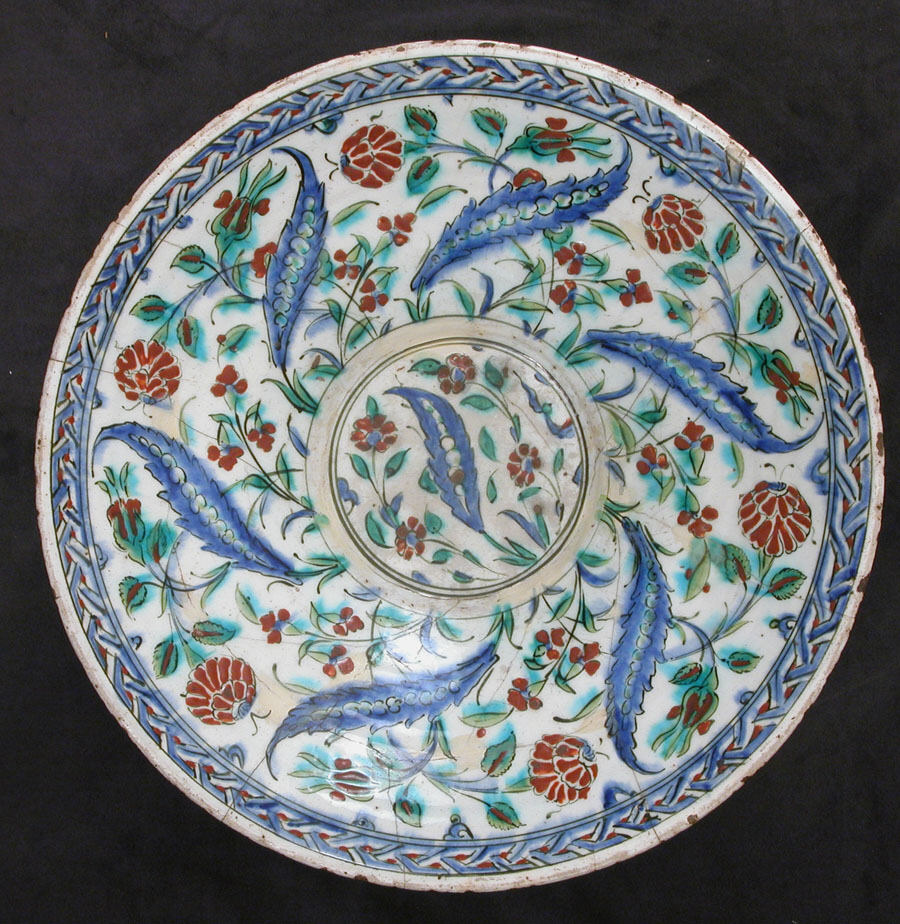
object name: bowl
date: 1601-1633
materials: stonepaste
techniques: glazing, painting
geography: turkey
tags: flowers,leaves